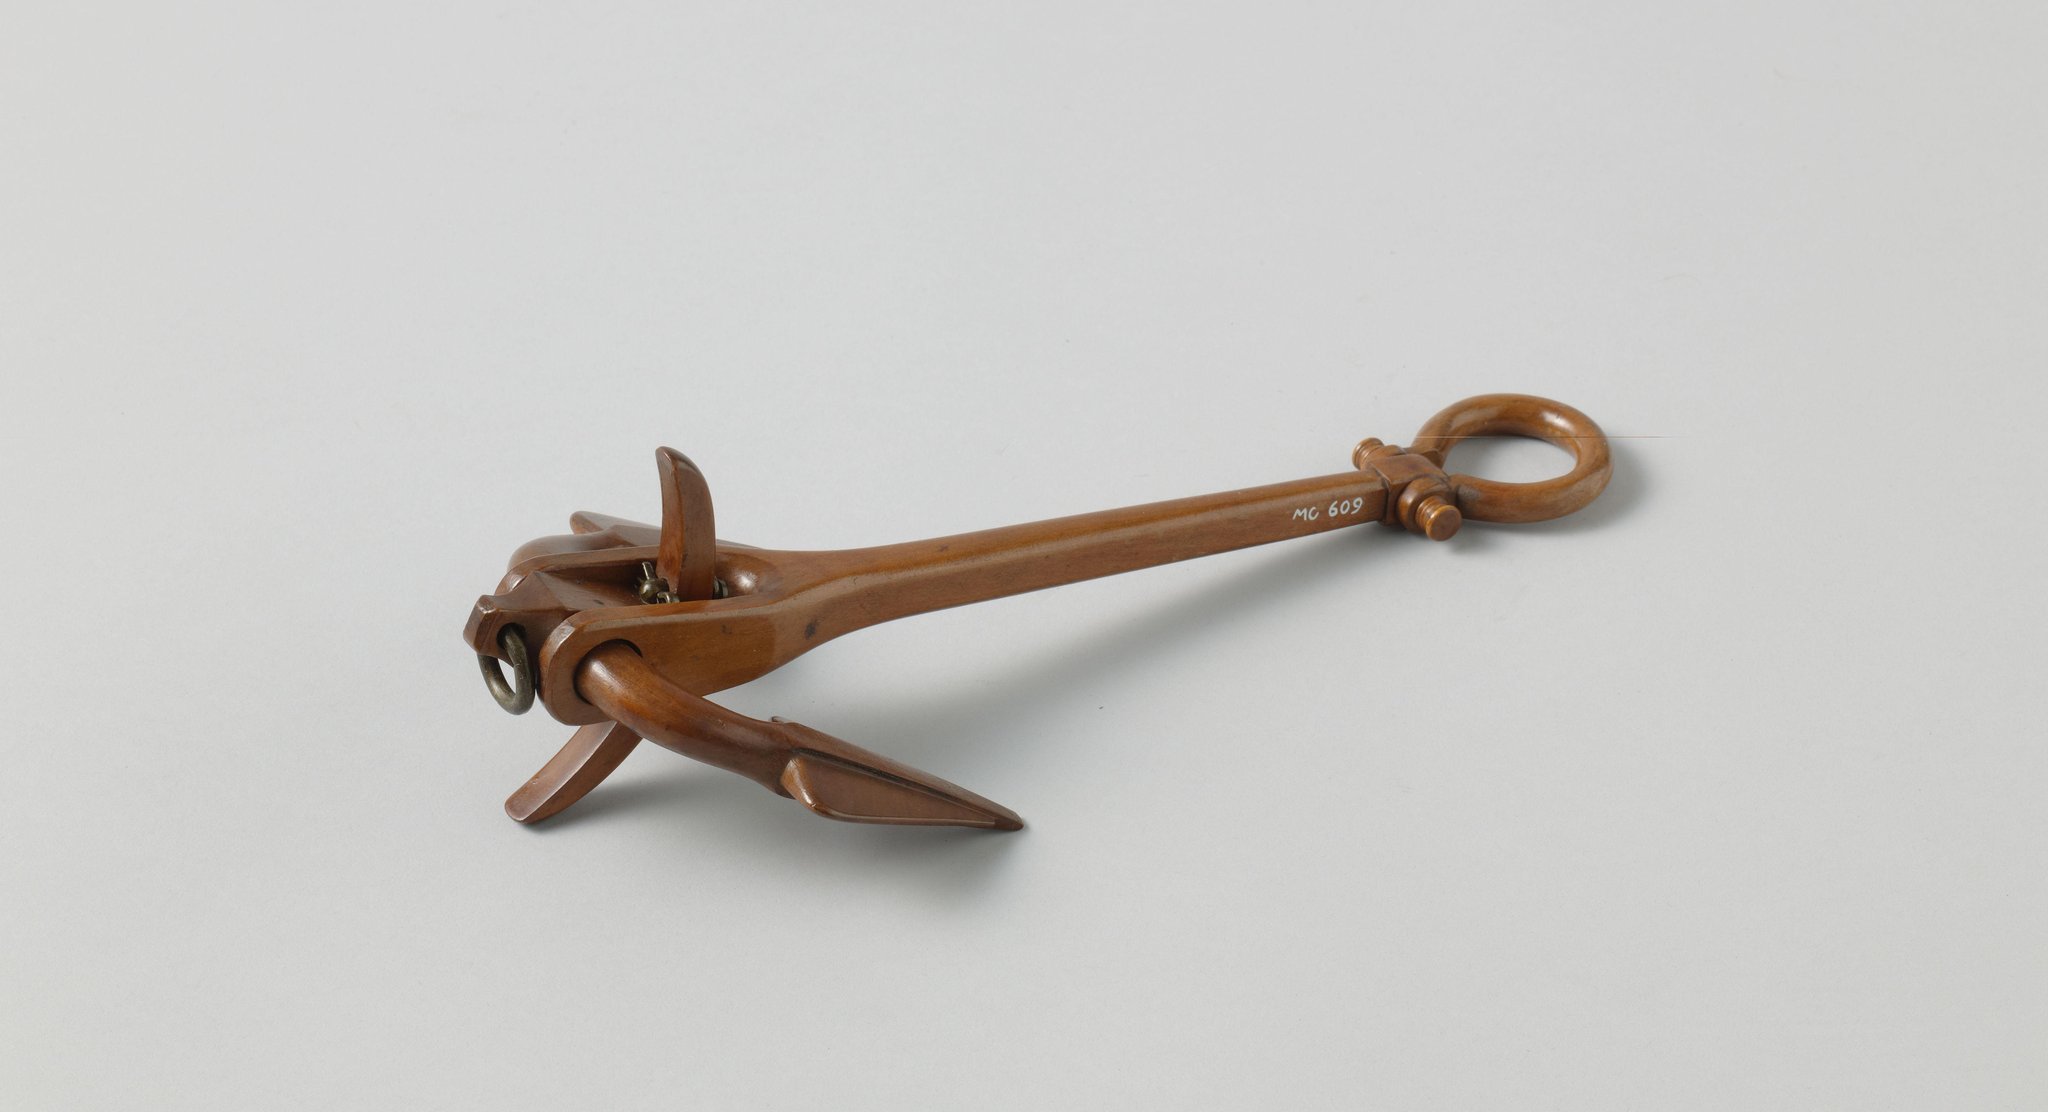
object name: demonstration model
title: Model of an Anchor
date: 1821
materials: bronze, wood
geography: netherlands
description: Hawkins' patent-anker werd door William Justin Dealy in Engeland in 1821 gepatenteerd en in Nederland in 1823, maar werd als R.F. Hawkins' patent-anker bij de Nederlandse Marine bekend. Het werd in 1825 op de korvet Pallas onder commando van J.C. Rijk beproefd. Het hield slecht in moddergrond.